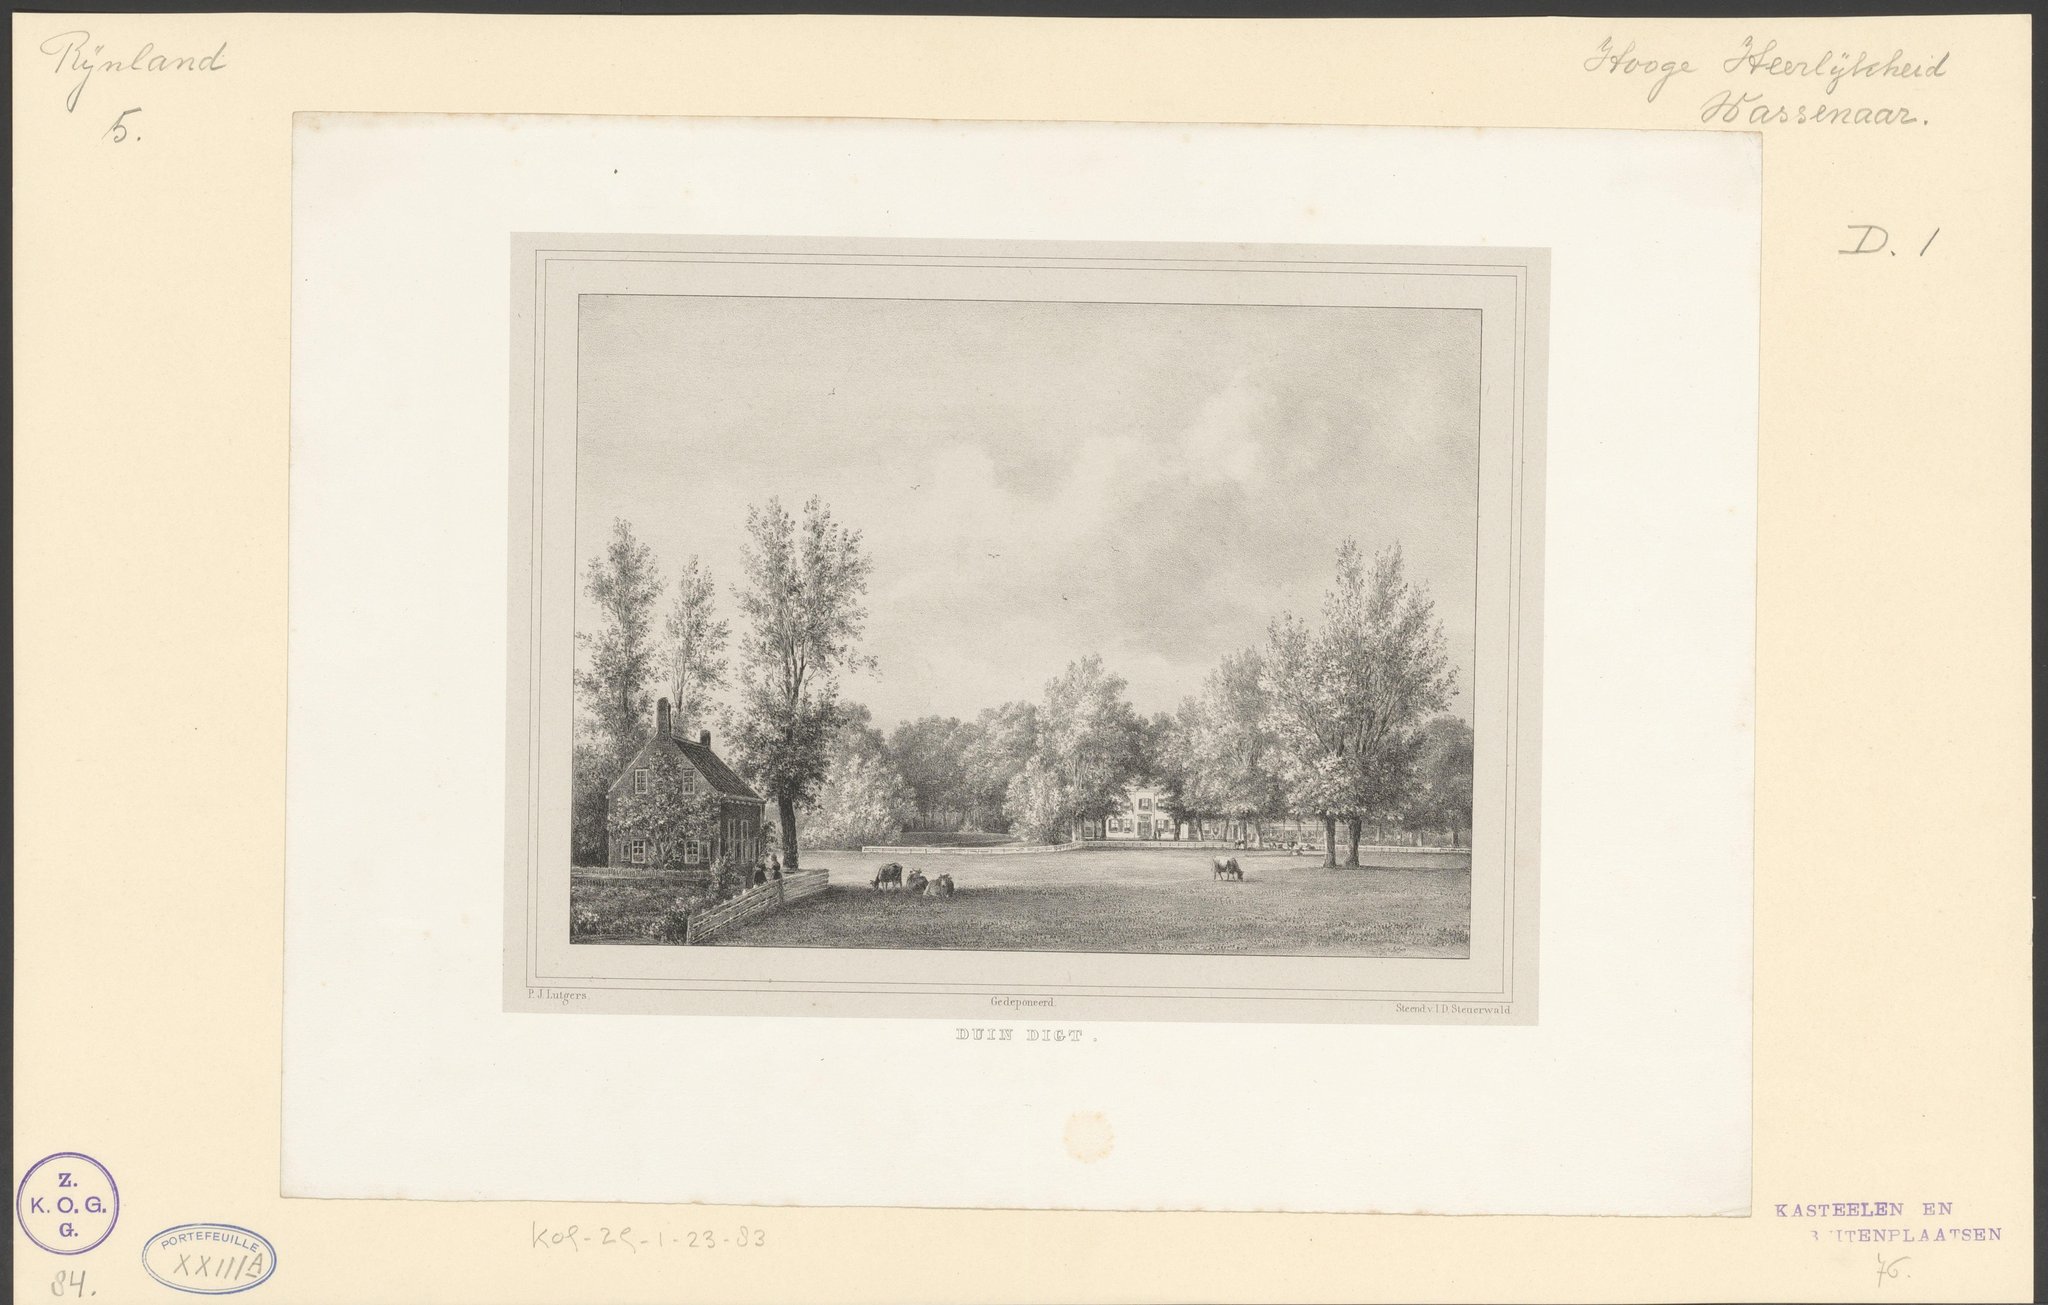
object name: print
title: Duin Digt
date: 1855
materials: paper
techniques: lithograph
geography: the hague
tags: trees, farm or solitary house in landscape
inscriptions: collector's mark: Lugt 1641, stamp, stamp, : ‘Gedeponeerd’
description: Onderwerpsrubrieken binnen de Atlas Zeden en Gewoonten: Zeden en Gewoonten in Engeren Zin, De Woning. Kastelen en buitenplaatsen. Holland.